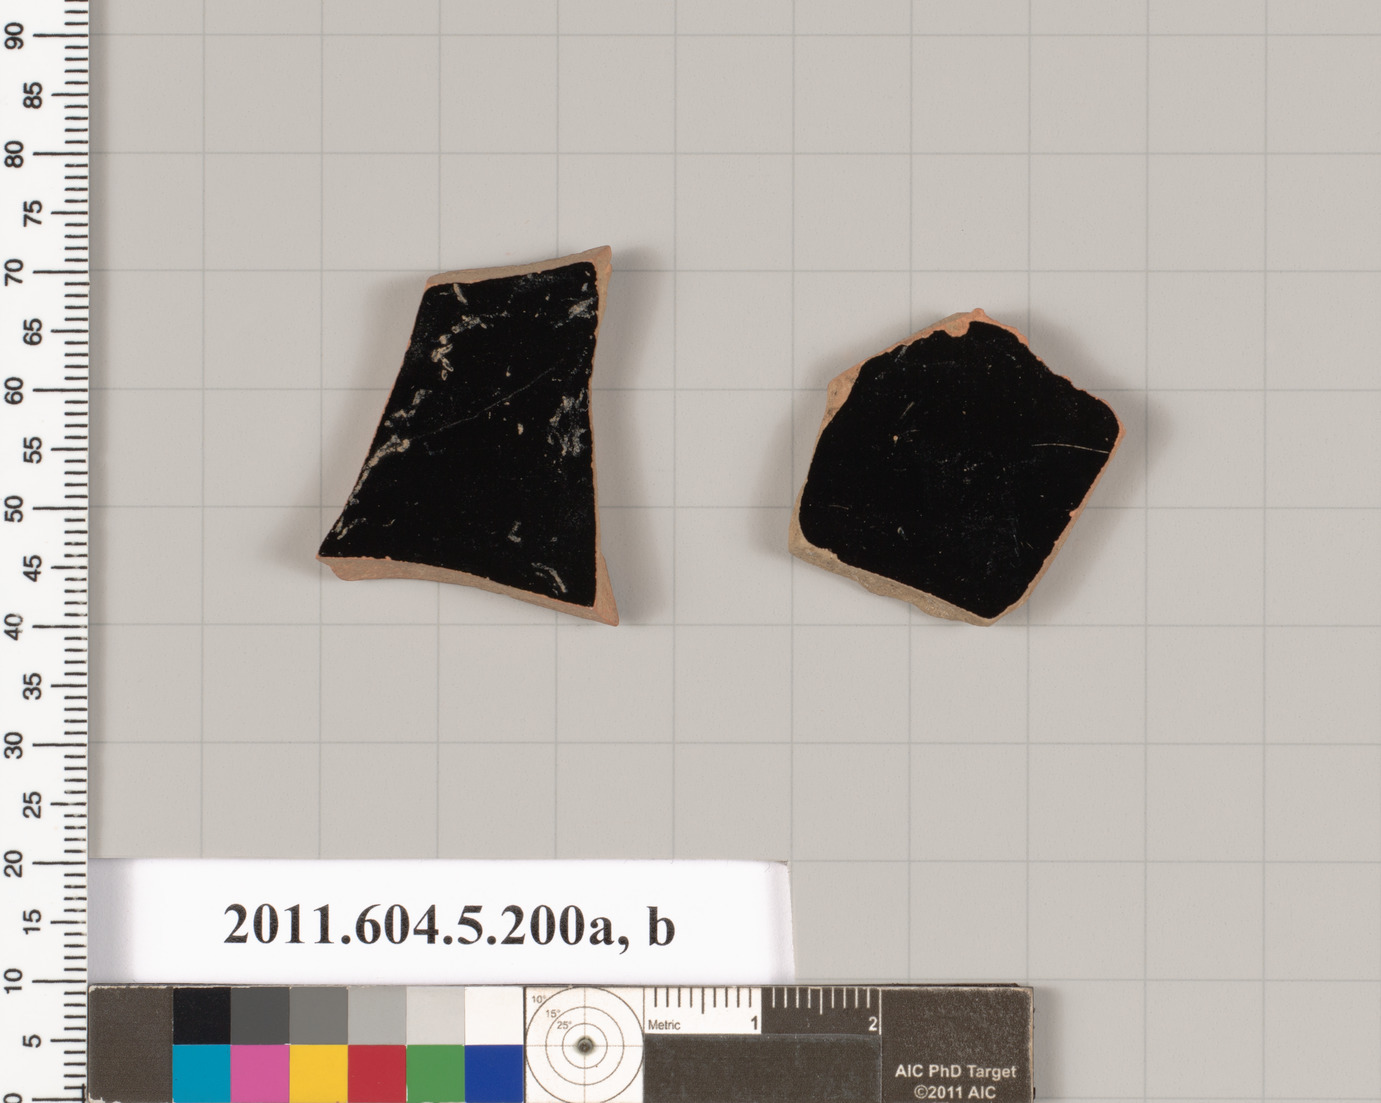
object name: kylix fragment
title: Terracotta fragments of kylikes (drinking cups)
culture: greek, attic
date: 600-401 BCE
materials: terracotta